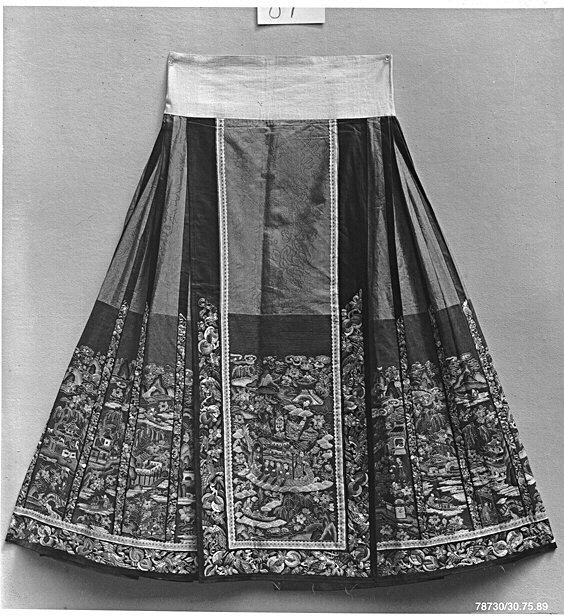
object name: skirt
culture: chinese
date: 1801-1900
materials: metal thread, silk